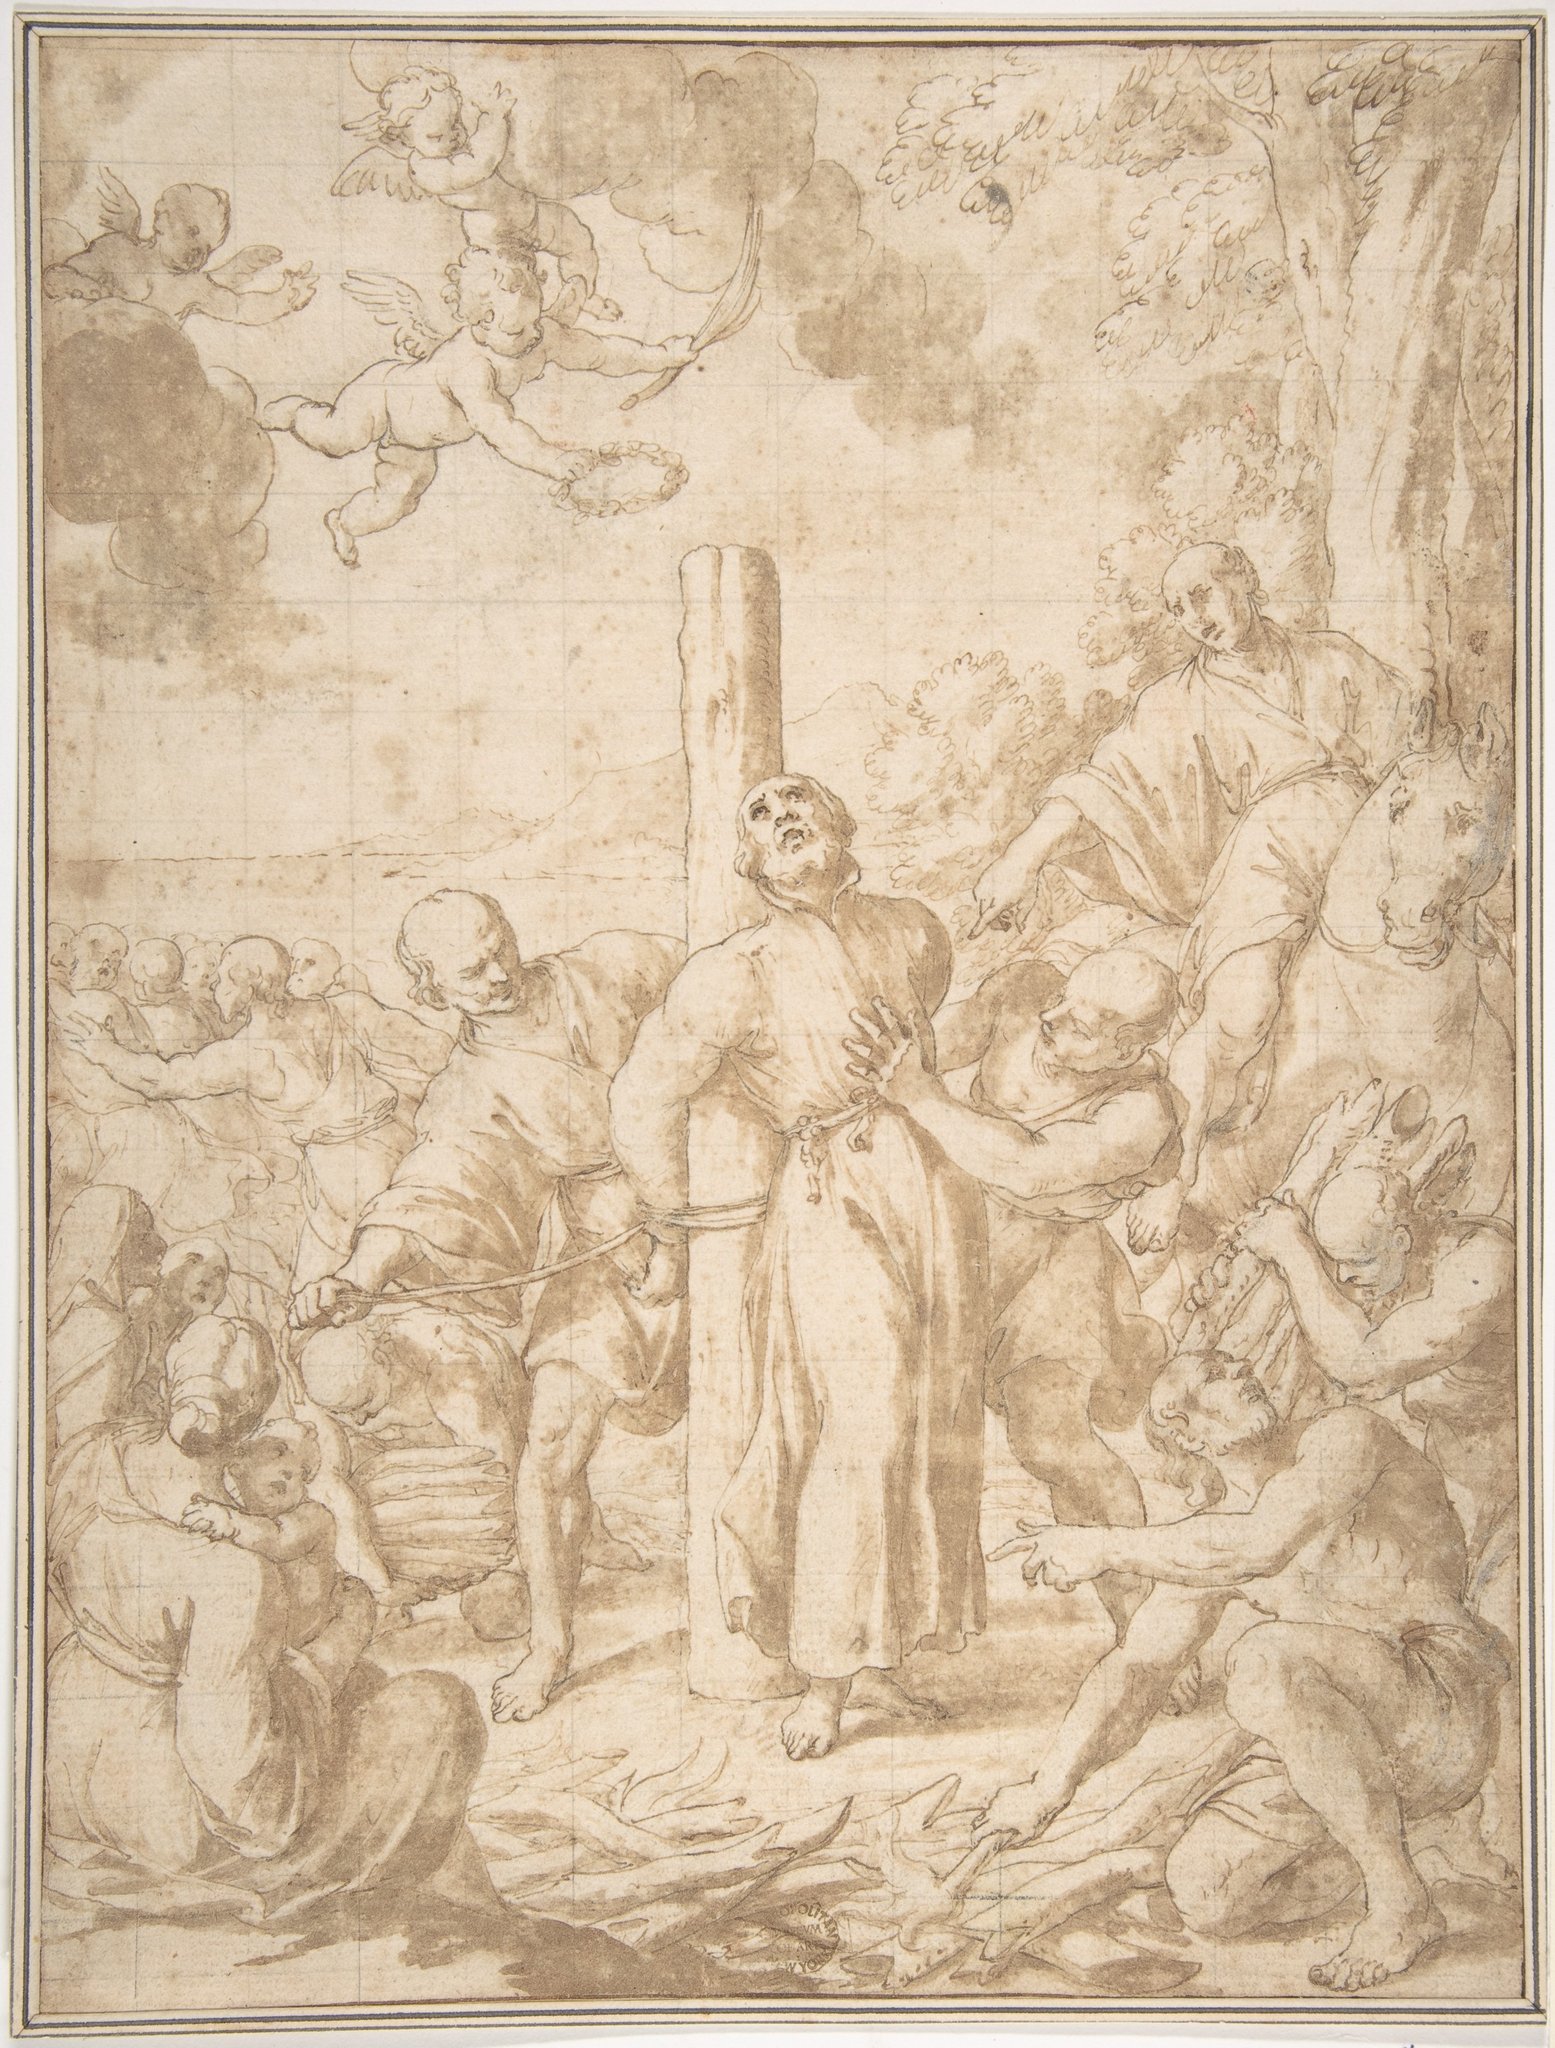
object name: drawing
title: A Martyrdom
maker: serafino brizzi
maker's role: artist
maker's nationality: italian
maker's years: 1684-1737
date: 1648-1737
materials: chalk, ink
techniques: brush, pen, drawing, wash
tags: suffering,men,women,horses,saint anthony